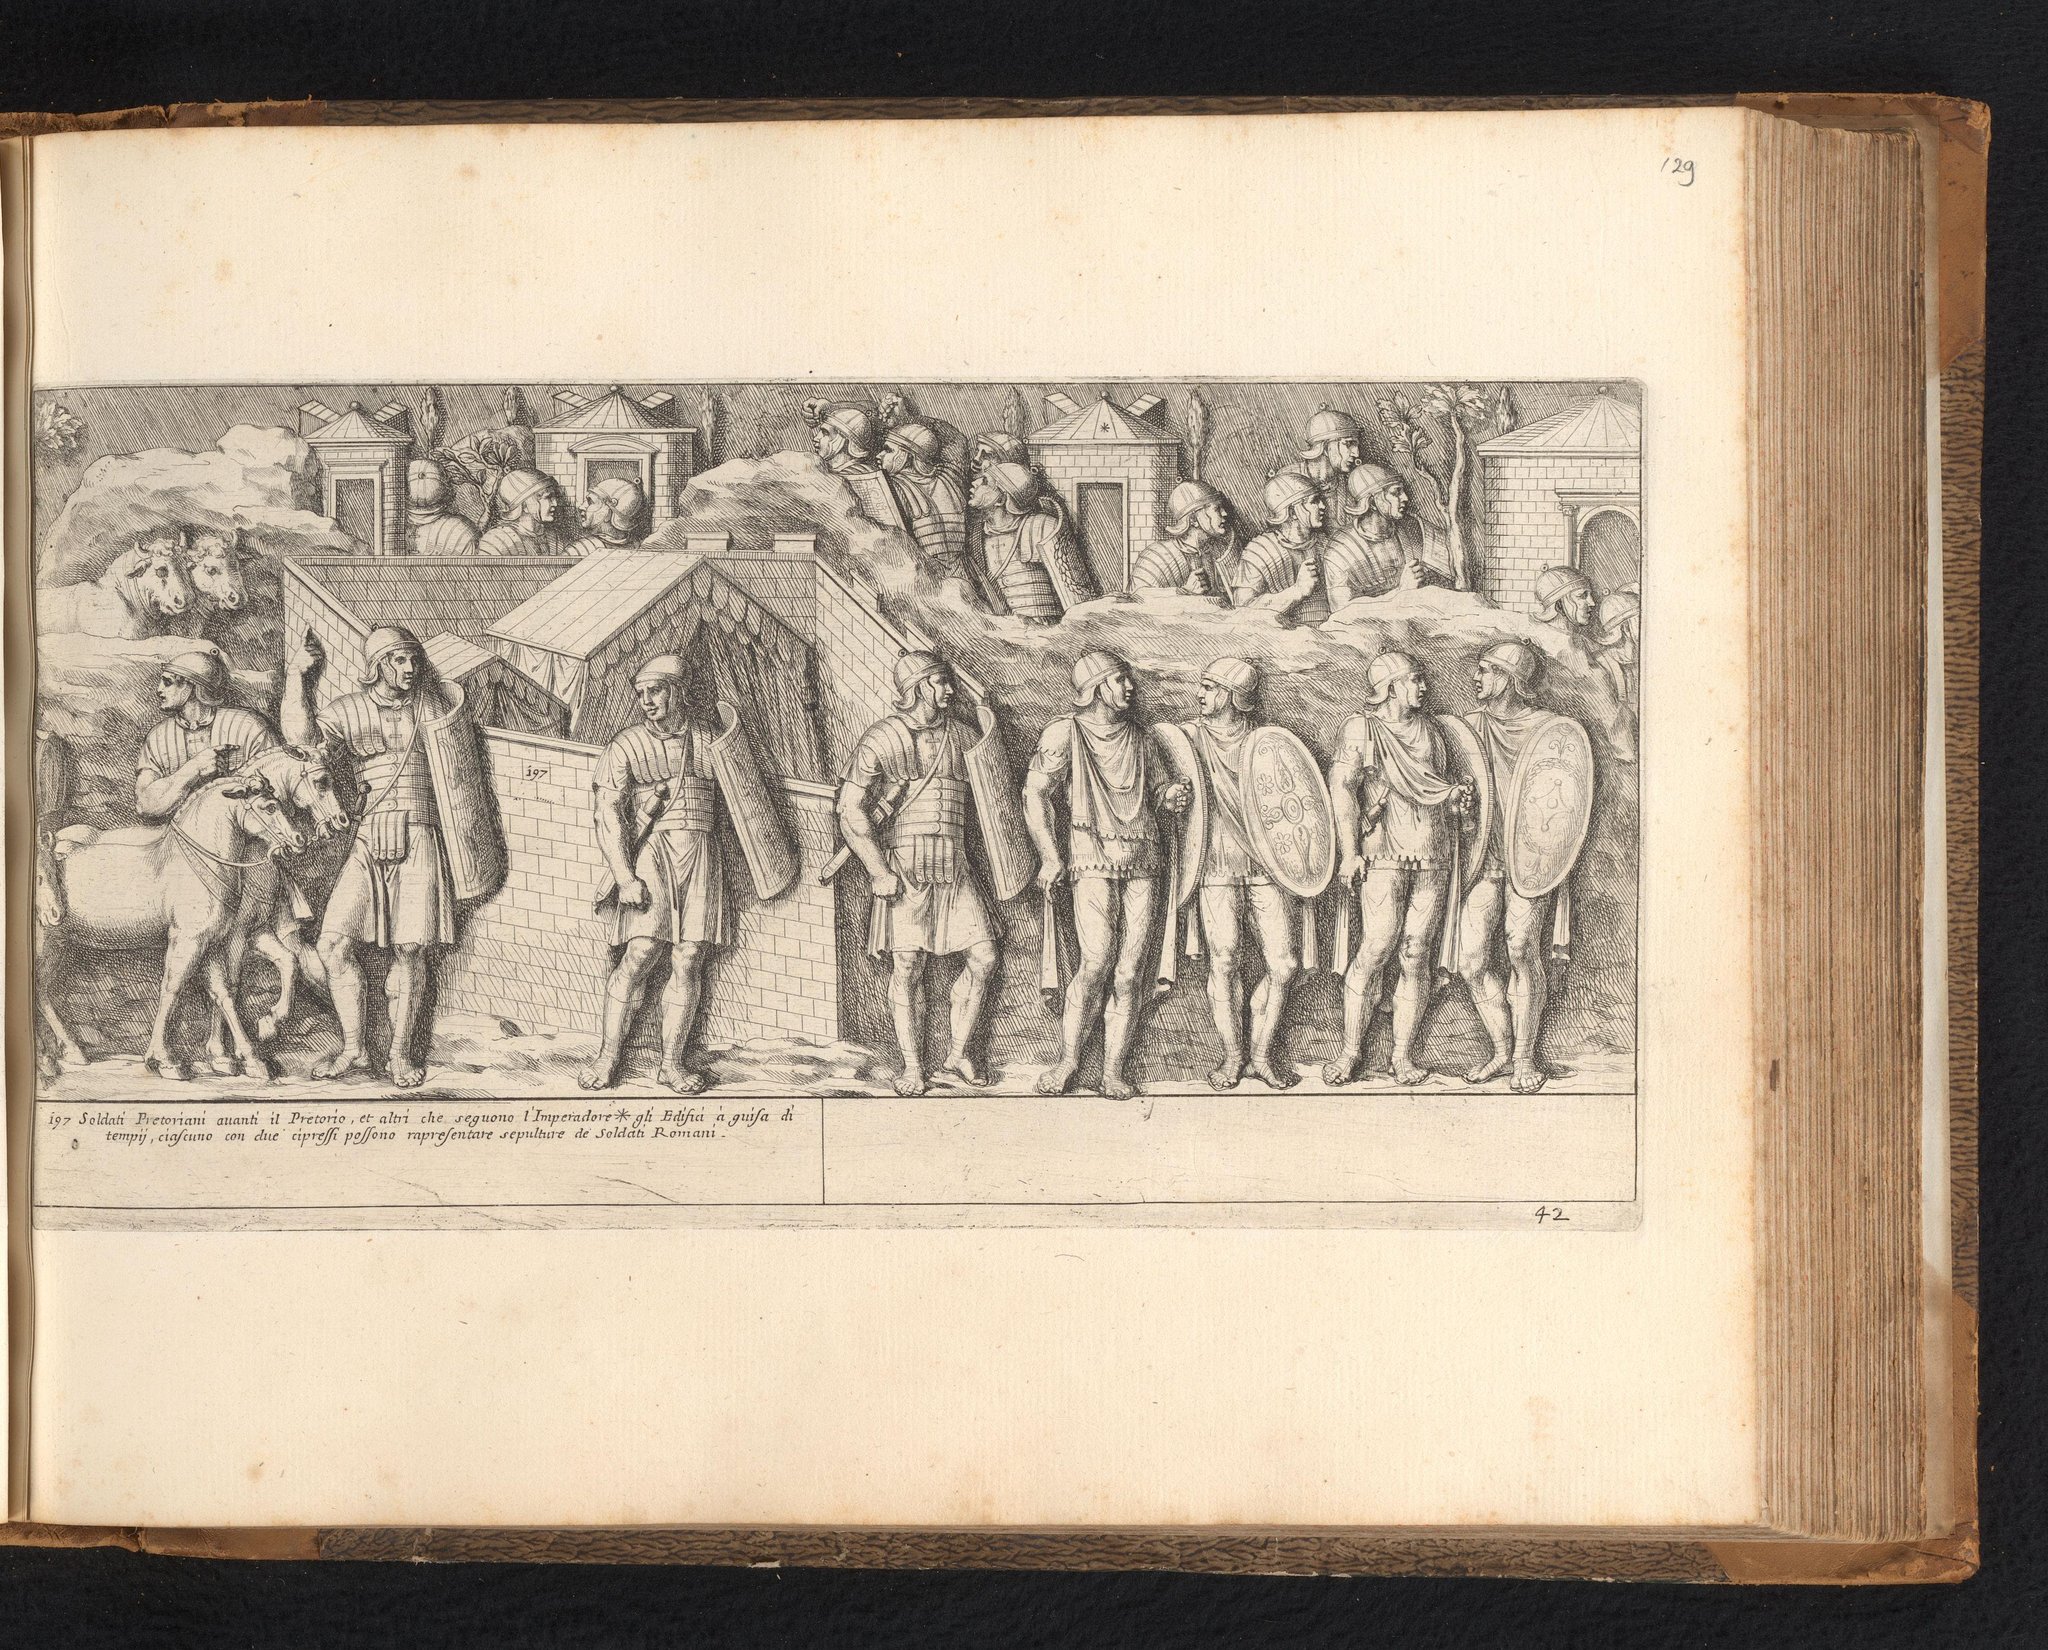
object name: album leaf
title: Detail van het fries op de Zuil van Trajanus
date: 1637-1691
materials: paper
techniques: etching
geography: rome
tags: triumphal column with helical friezes, piece of sculpture, reproduction of a piece of sculpture, the soldier; the soldier's life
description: Detail van het spiraalvormige gebeeldhouwde fries op de Zuil van Trajanus. Het fries toont de oorlogen tussen de Romeinen en de Daciërs. Verklarende nummers in de ondermarge. Prent maakt deel uit van een album.